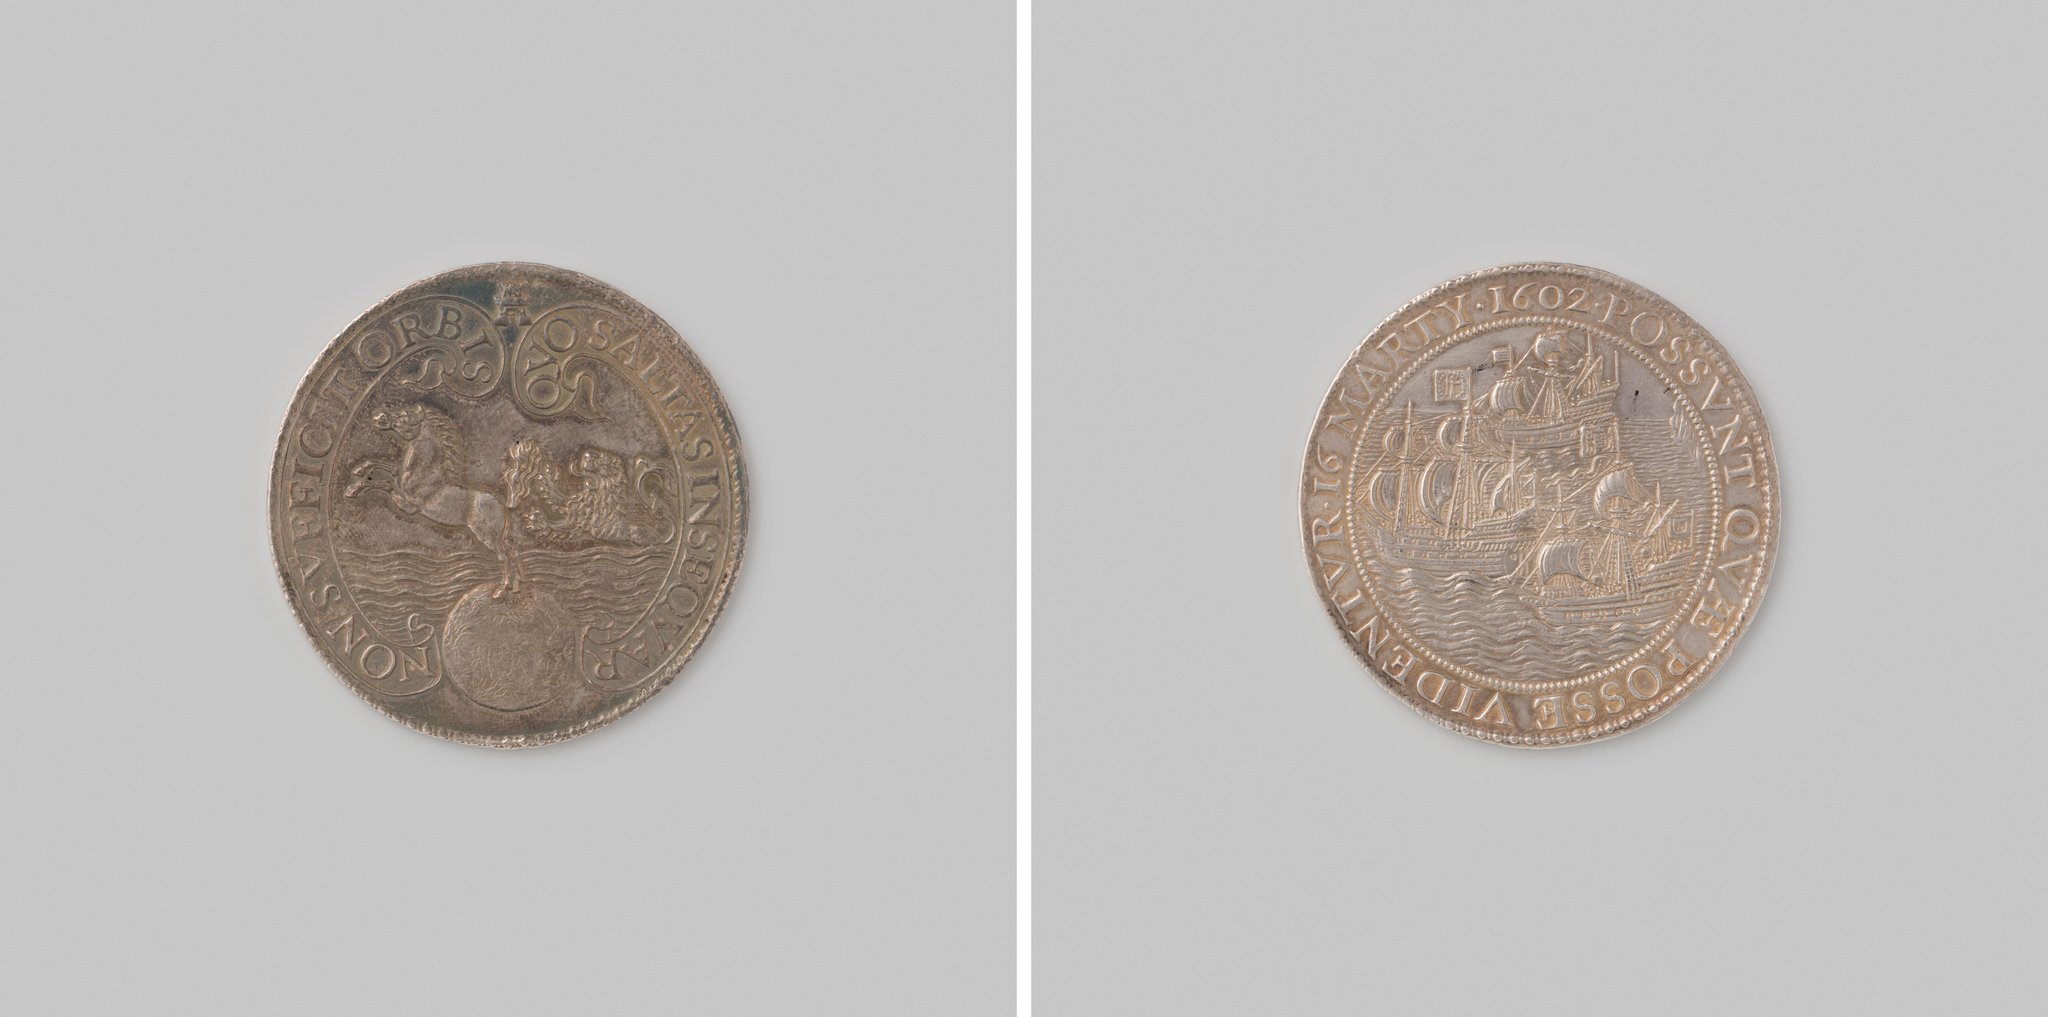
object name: history medal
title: De verovering van het Spaanse galjoen St. Jacob door de Zeeuwse schepen van De Roy en Bikker 1601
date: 1601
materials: silver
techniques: striking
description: Zilveren penning, op de voorzijde een paard dat naar de andere zijde van de wereld springt, gevolgd door de Zeeuwse leeuw, met een omschrift op twee linten waartussen een burchtje, op de keerzijde drie schepen op volle zee, met omschrift.